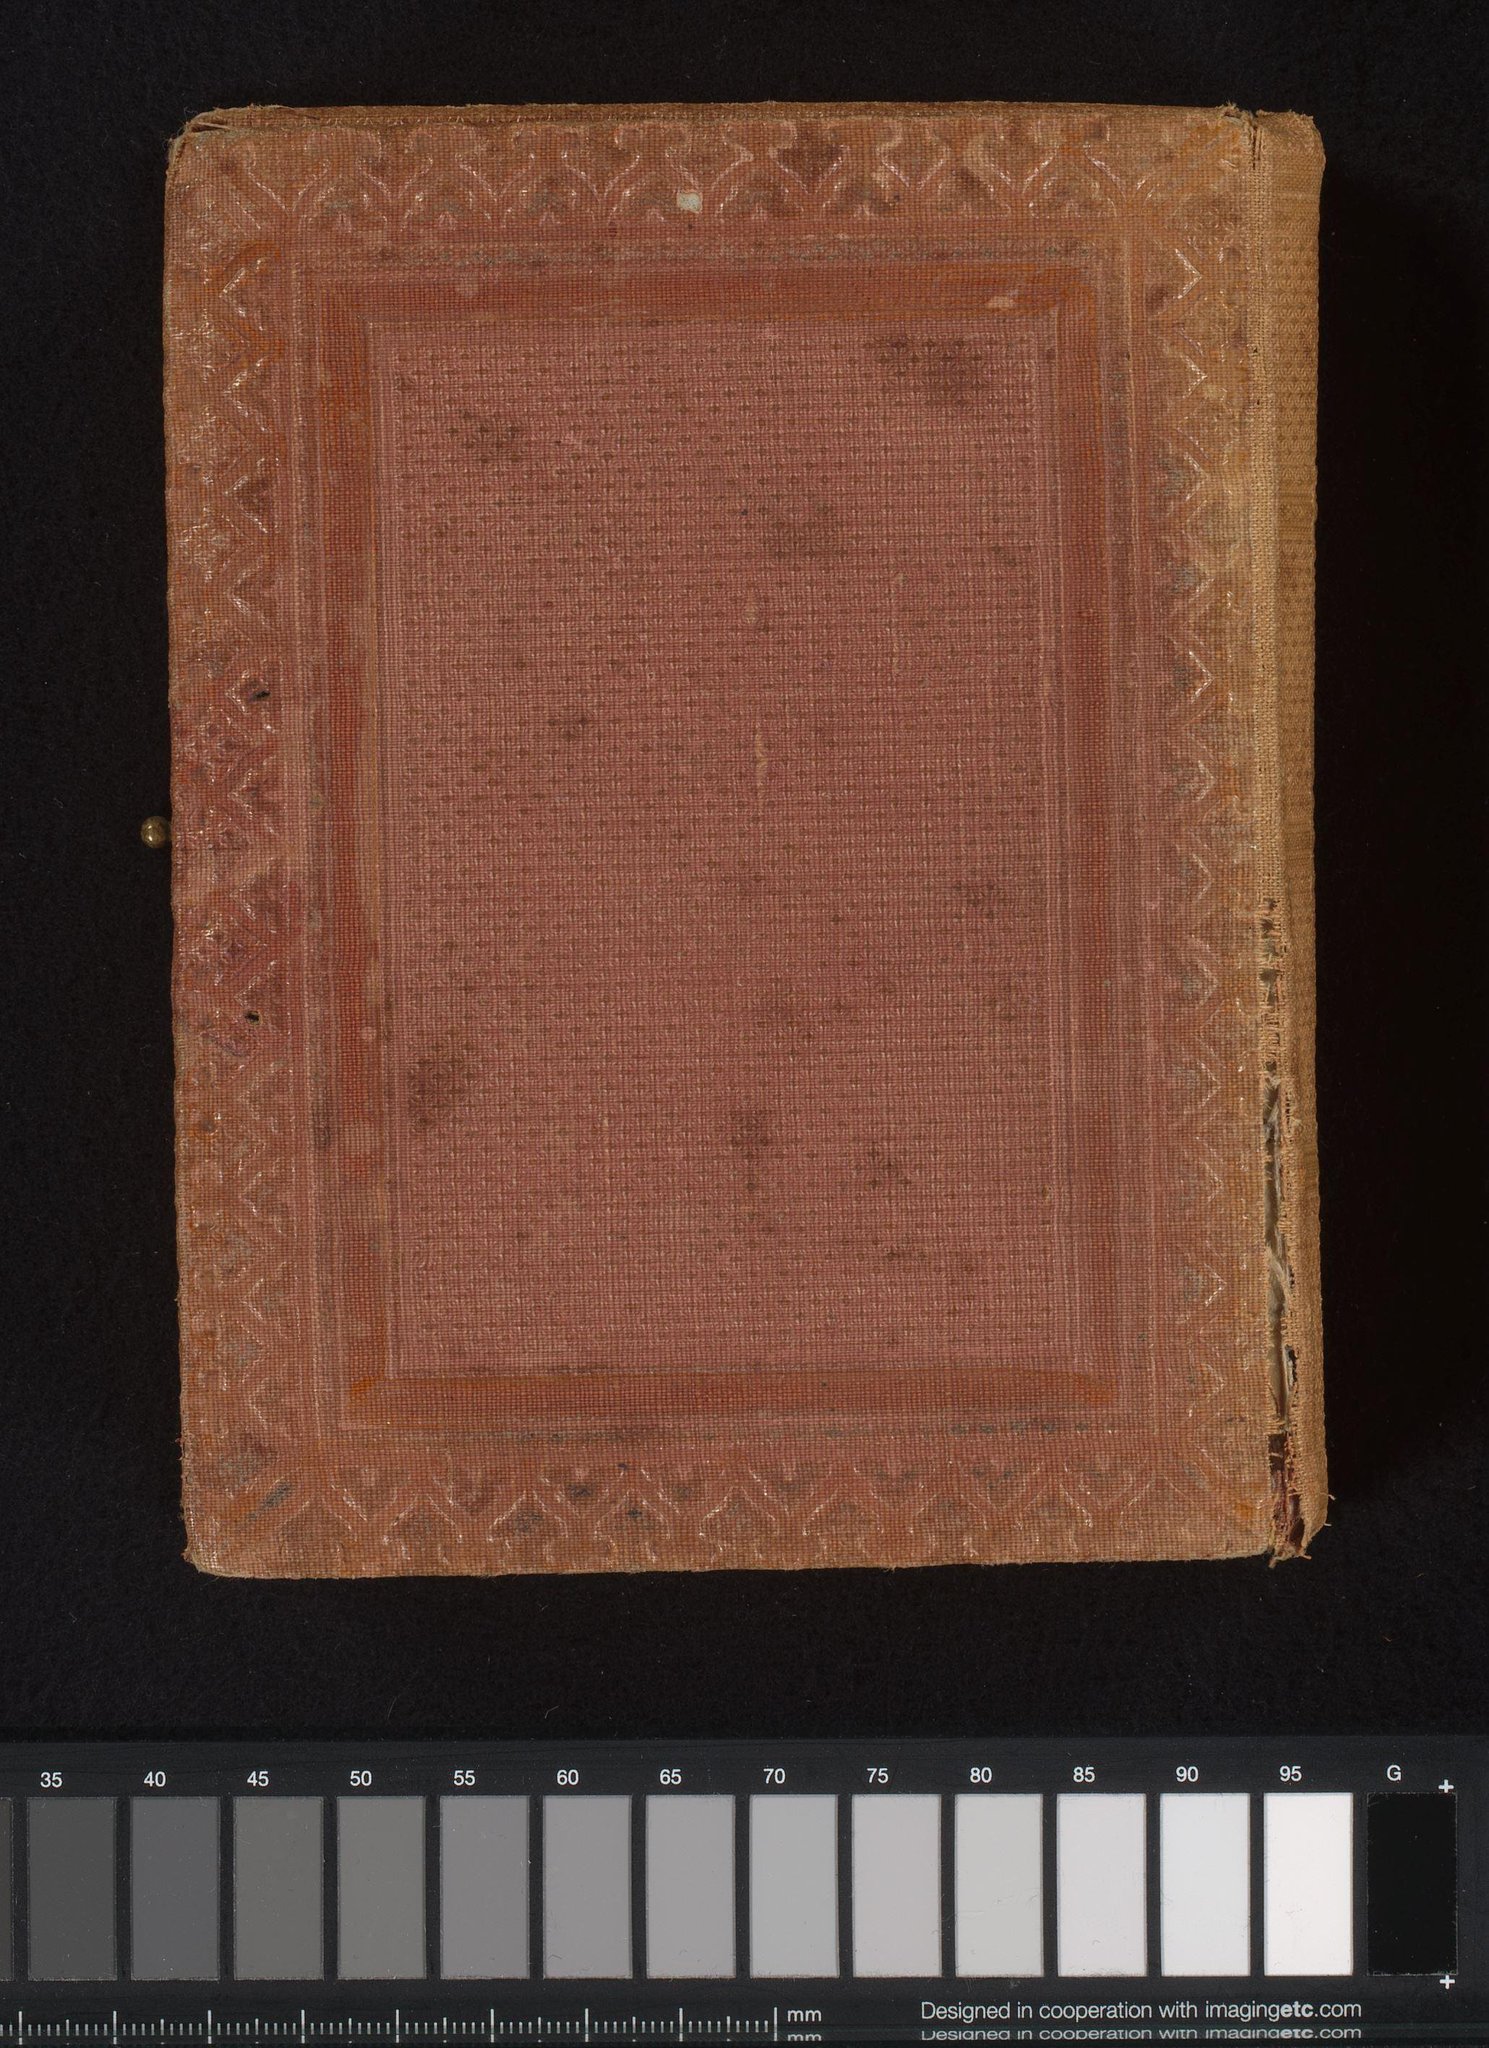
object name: album leaf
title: Portret van een jonge vrouw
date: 1860-1900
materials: cardboard, photographic support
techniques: albumen print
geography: frankfurt am main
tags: adolescent, young woman, maiden, historical persons - bb - woman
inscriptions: inscription: ‘Photographisches/ Atelier/ von/ Straub & Kühn/ Frankfurt a/M/ Zeil 70./ Haus Mozart.’